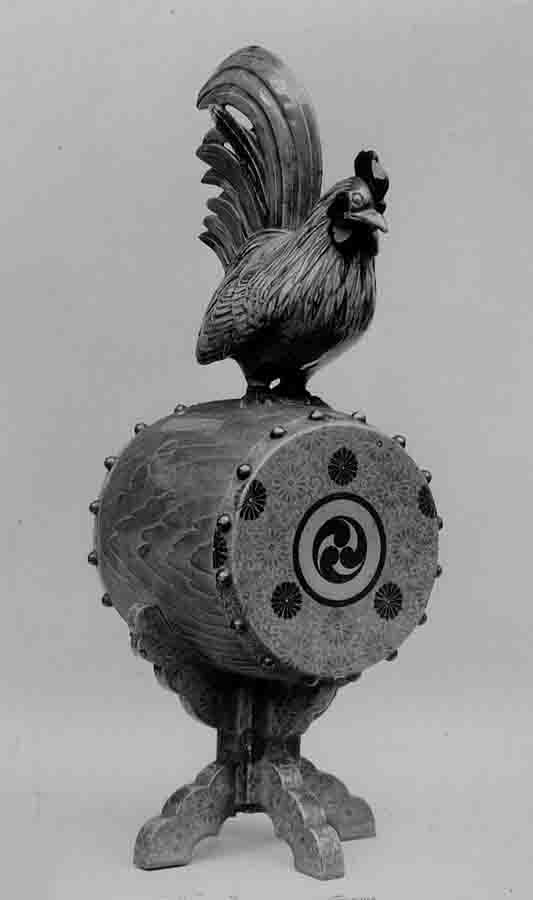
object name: censer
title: Censer in the Form of a Cock on a Drum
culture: japanese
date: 1800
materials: enamel, gold, stoneware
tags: drums,censers